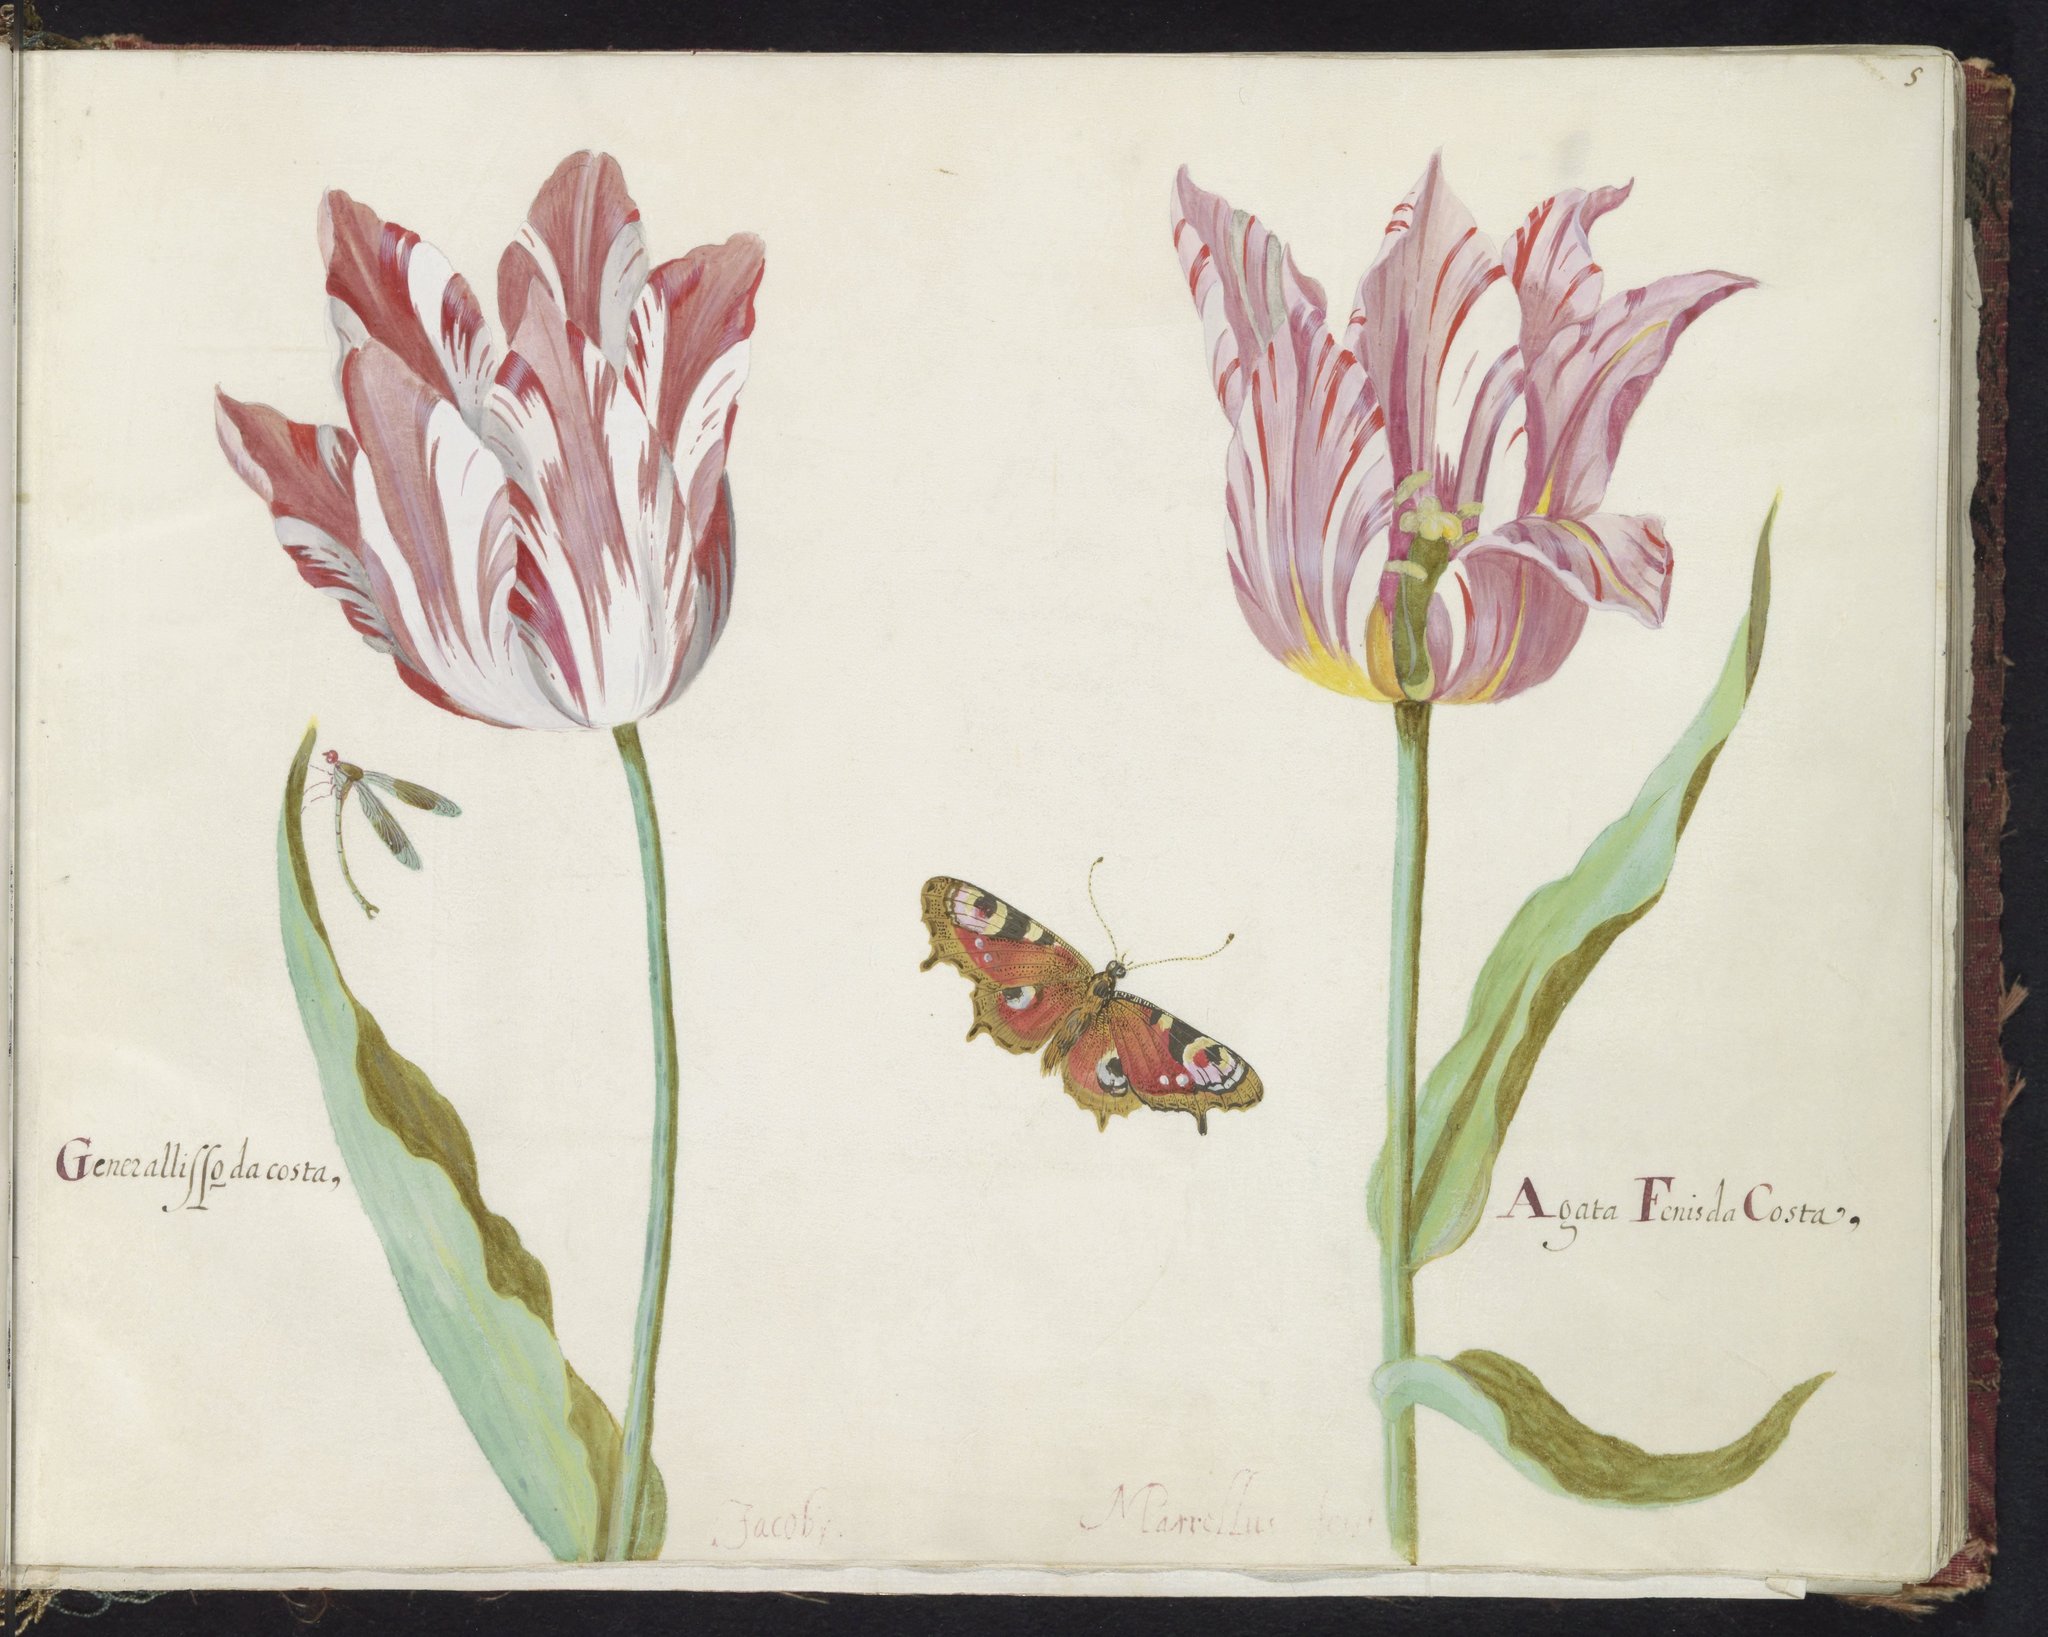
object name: drawing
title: Generallisso da costa / Agata Fenis da Costa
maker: jacob marrel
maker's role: draughtsman, painter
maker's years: 1614-1681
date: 1637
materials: paint, parchment, pencil, watercolor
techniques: brush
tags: insects: dragon-fly, insects: butterfly, flowers: tulip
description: De tekening maakt deel uit van een album.